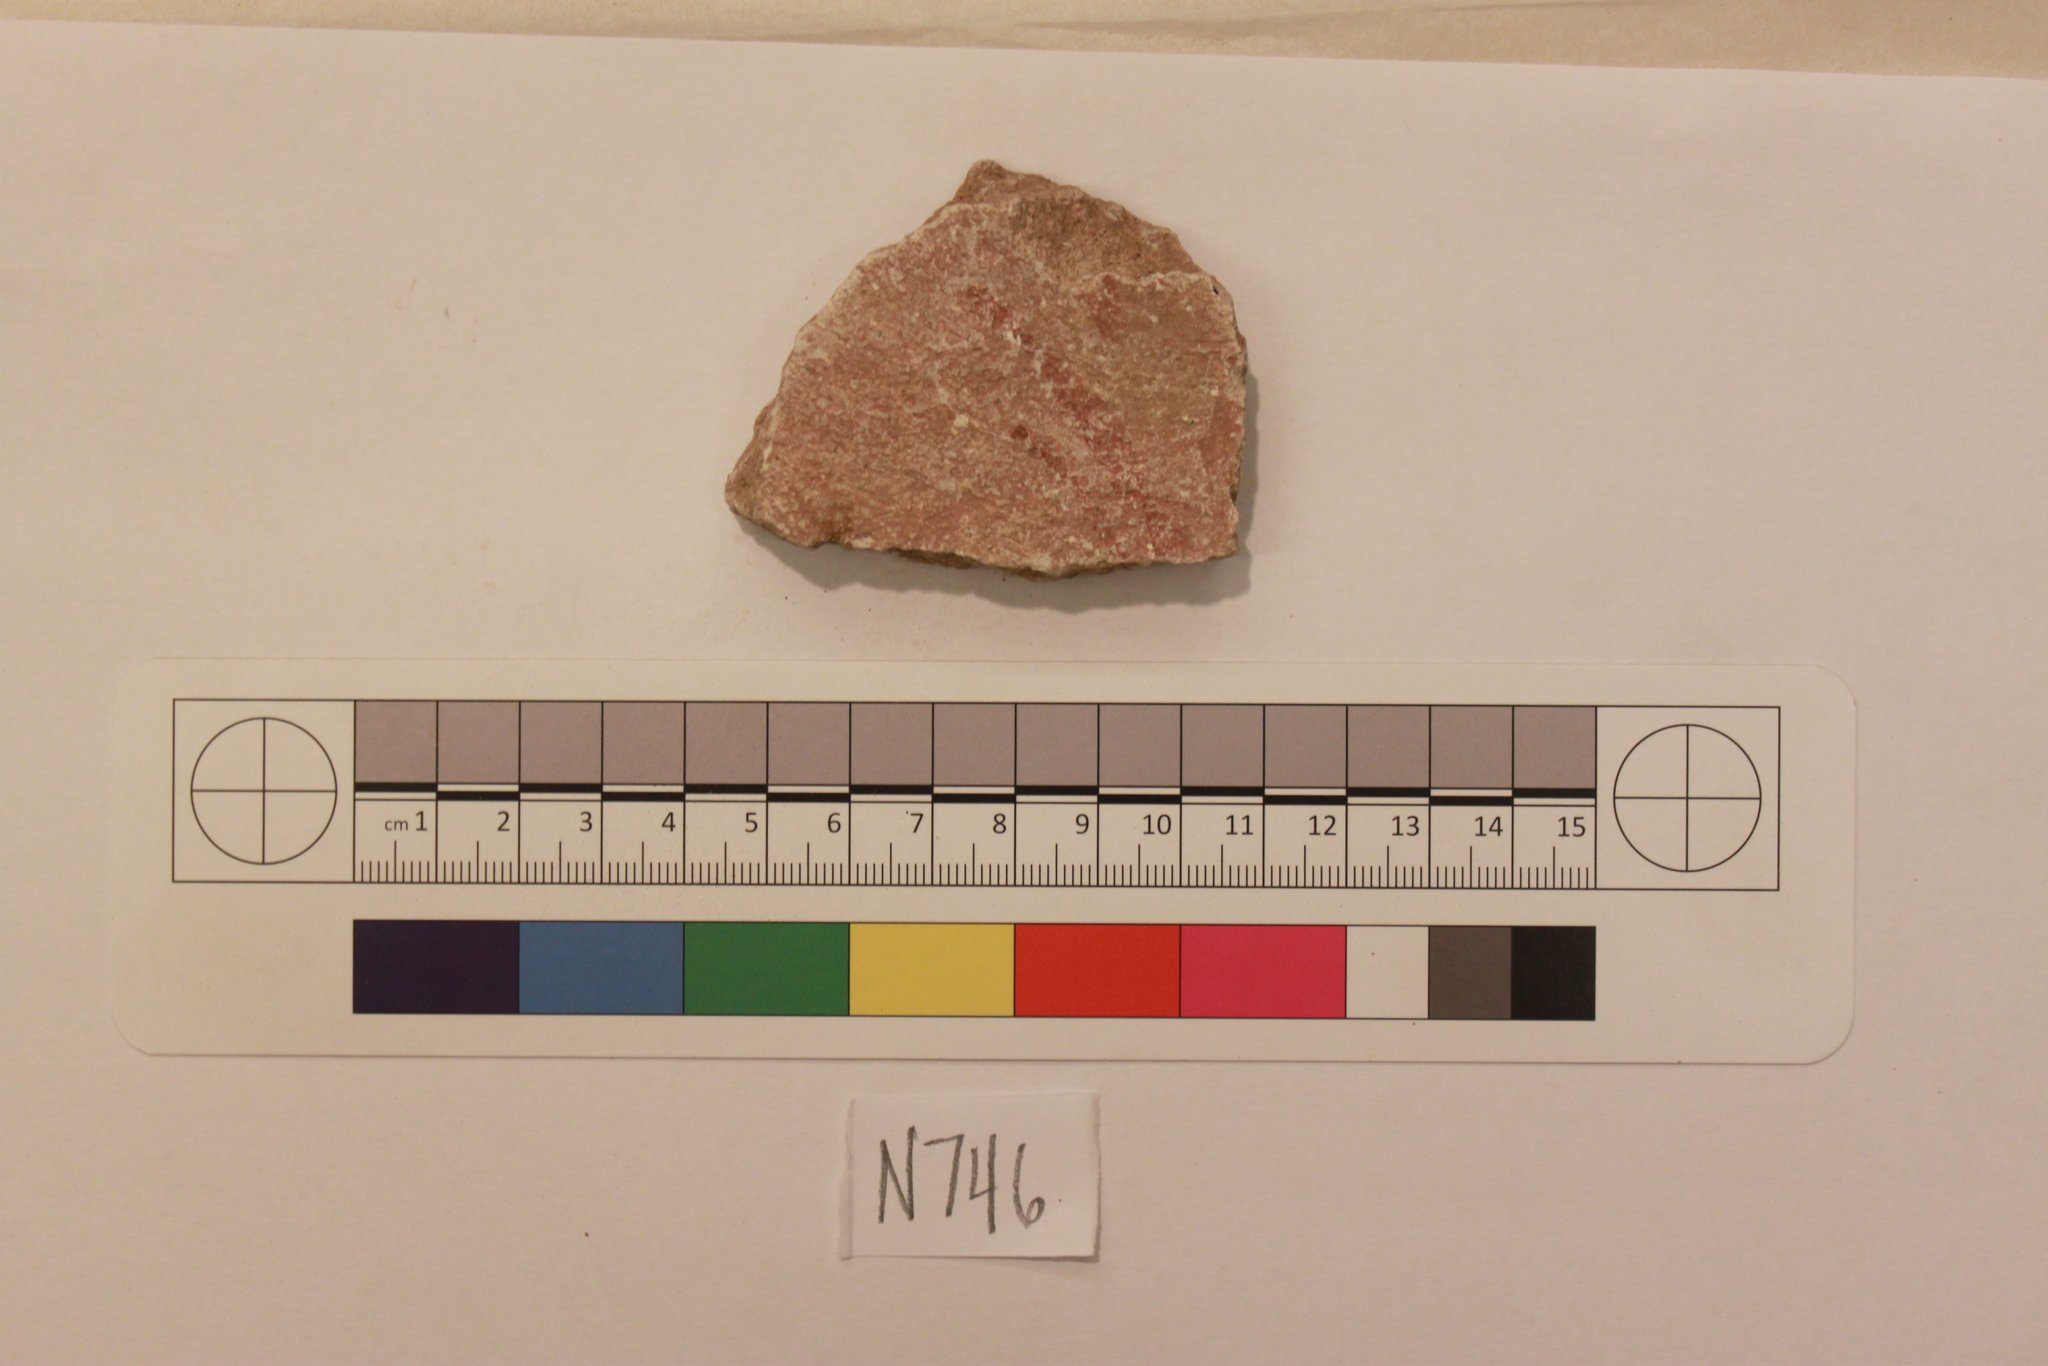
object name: fragment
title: Stucco Fragment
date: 701-1200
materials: plaster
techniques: carving, painting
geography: iran